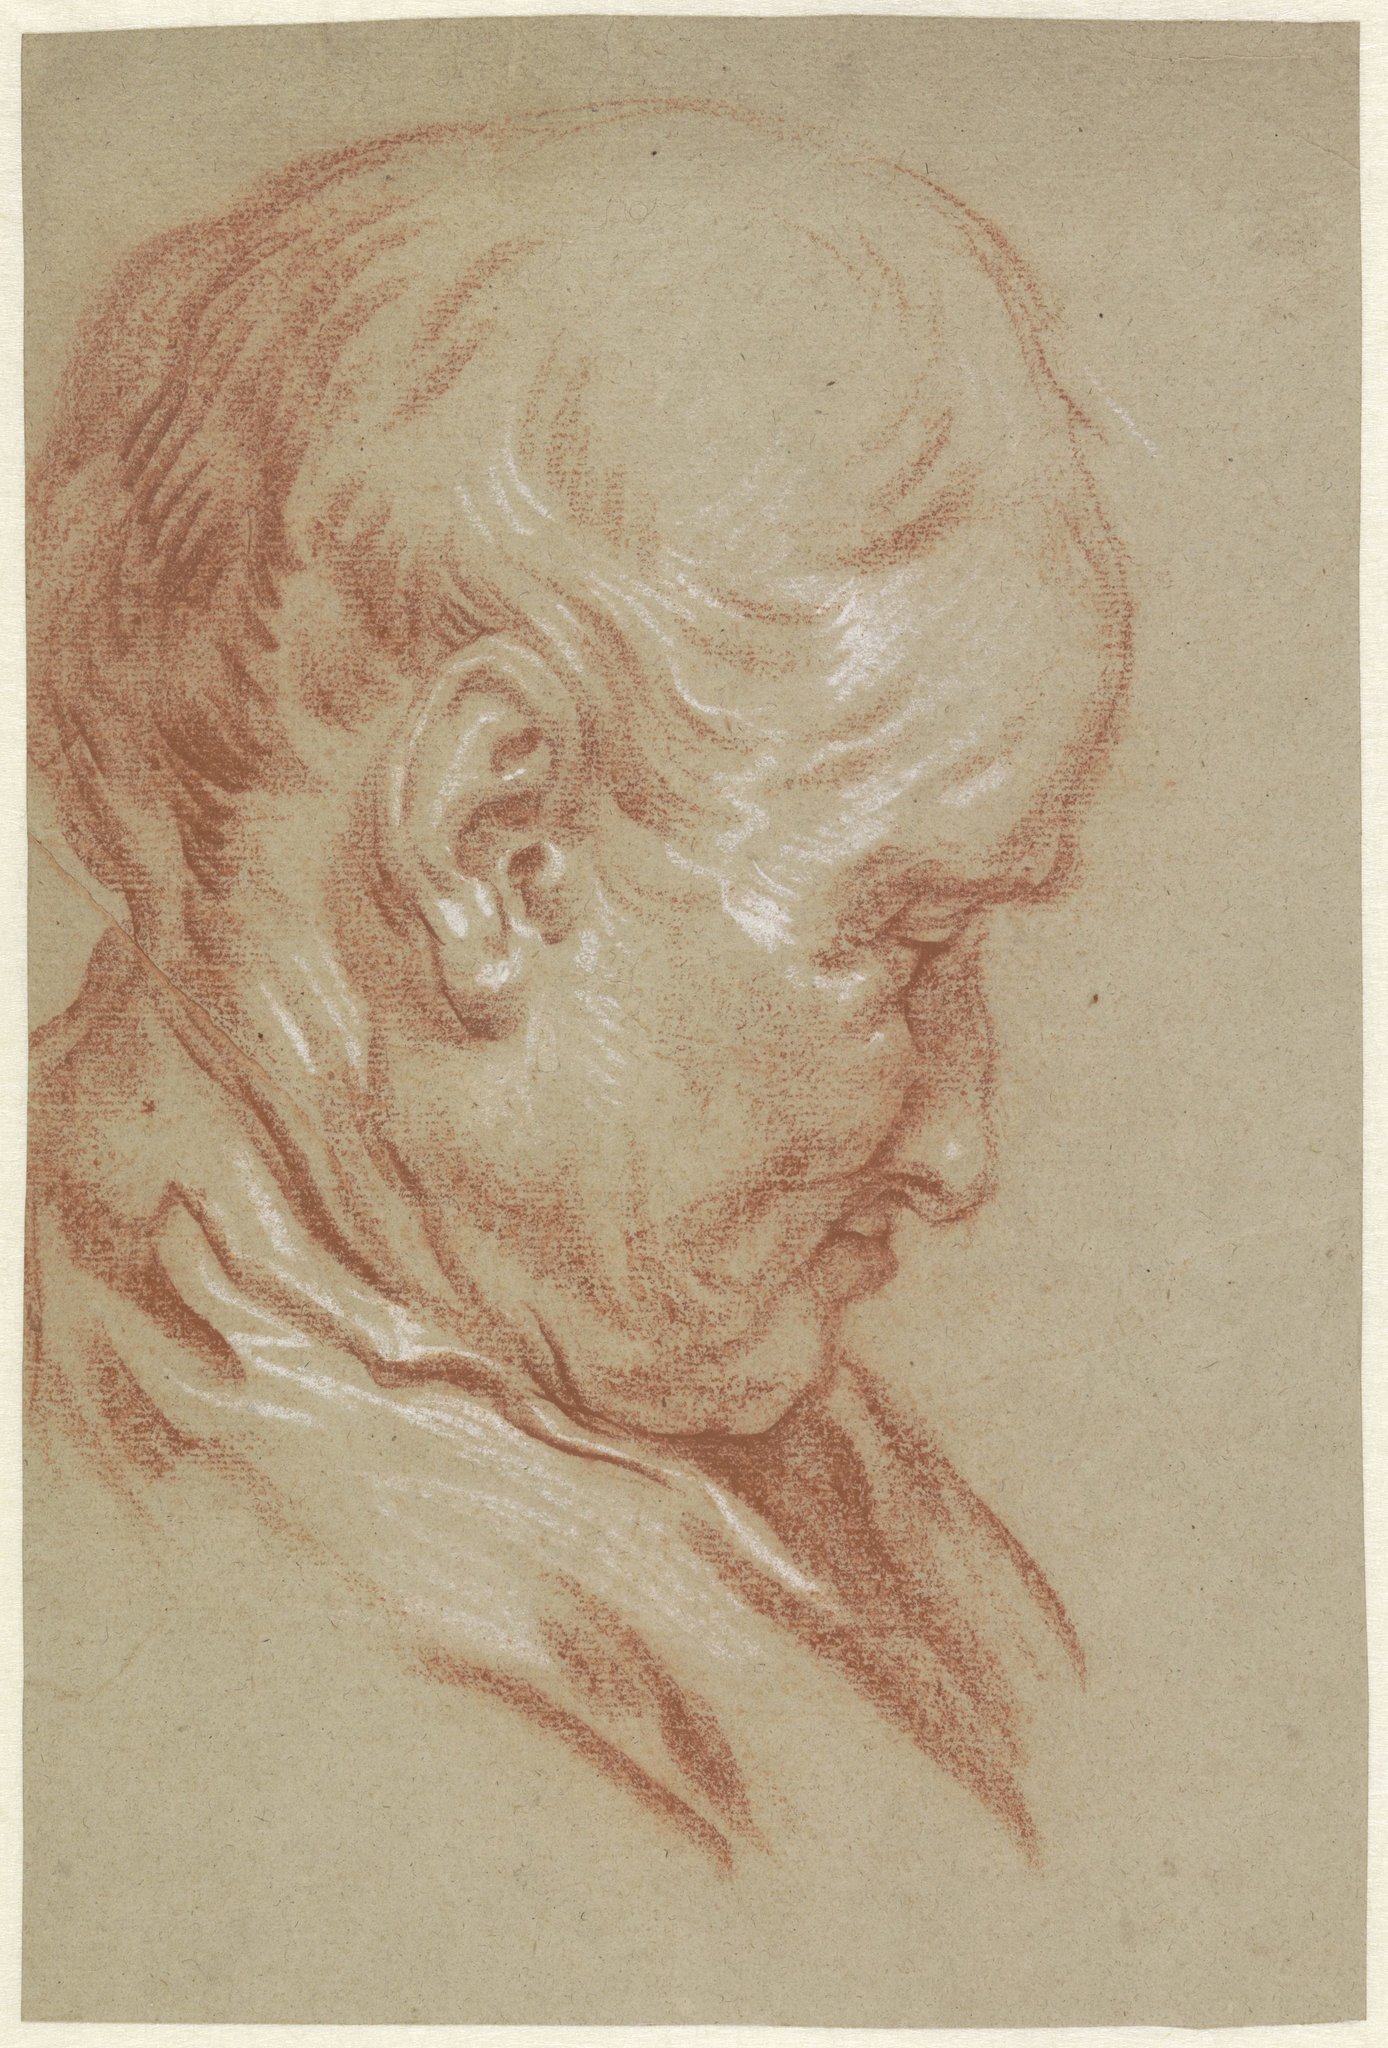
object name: drawing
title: Hoofd van een oude man, en profil naar rechts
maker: jan anton garemyn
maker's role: draughtsman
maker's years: 1712-1799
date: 1722-1799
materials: chalk, paper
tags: head (human), old man